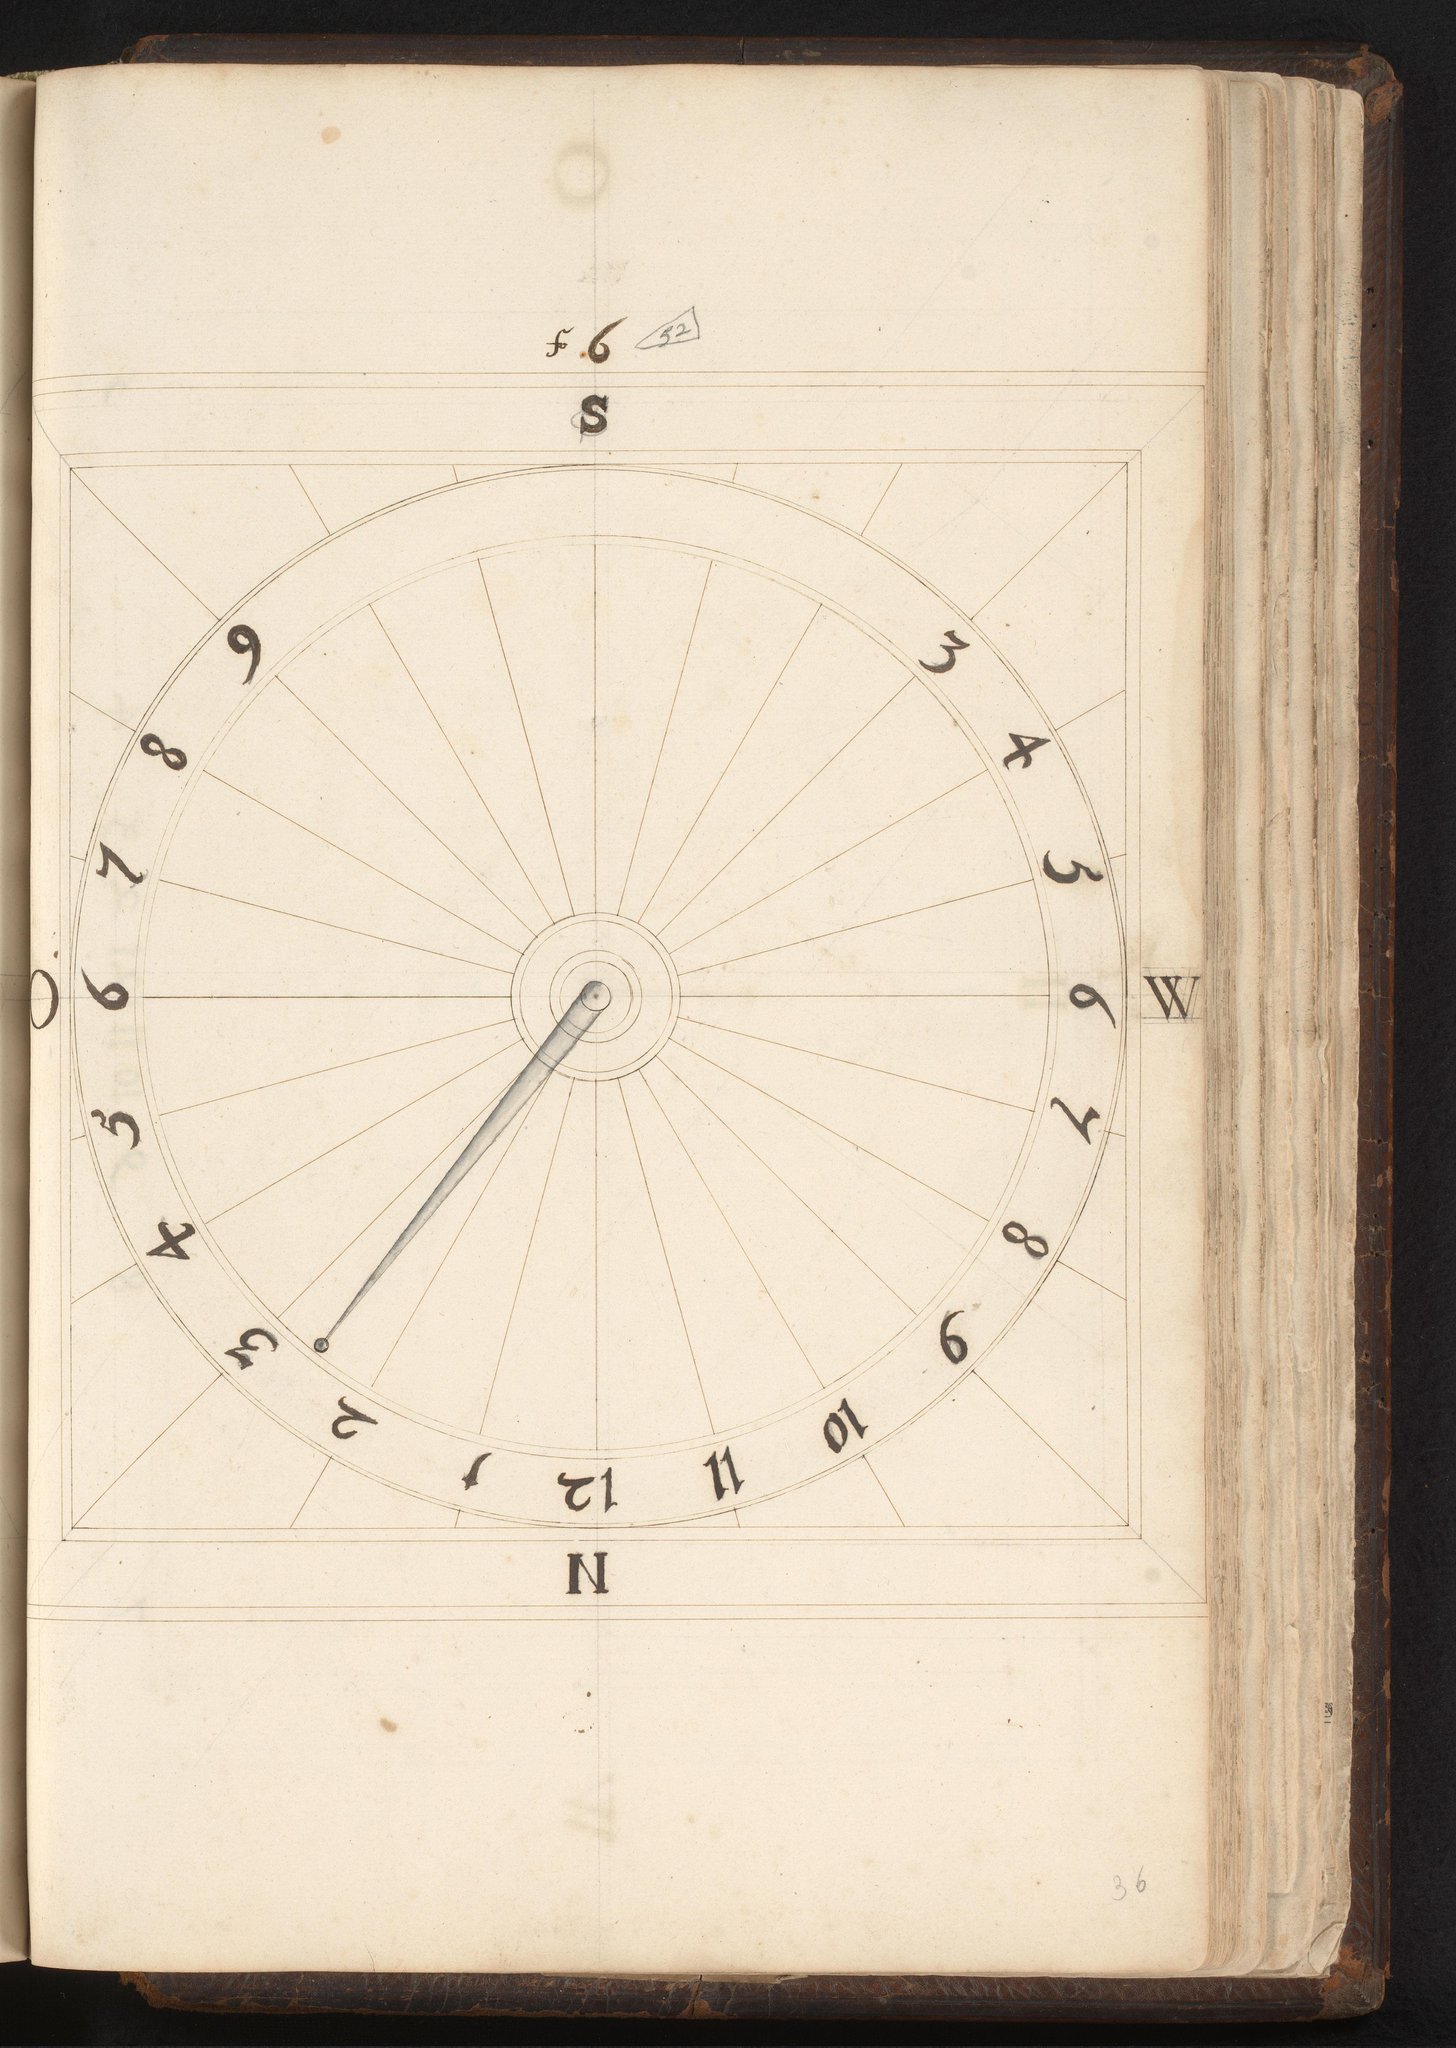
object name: album leaf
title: Ontwerp voor een zonnewijzer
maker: Anonymous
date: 1650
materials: ink, paper, pencil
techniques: brush, pen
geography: low countries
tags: sundial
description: Midden boven genummerd: Fo 6. Tekening maakt deel uit van een album.